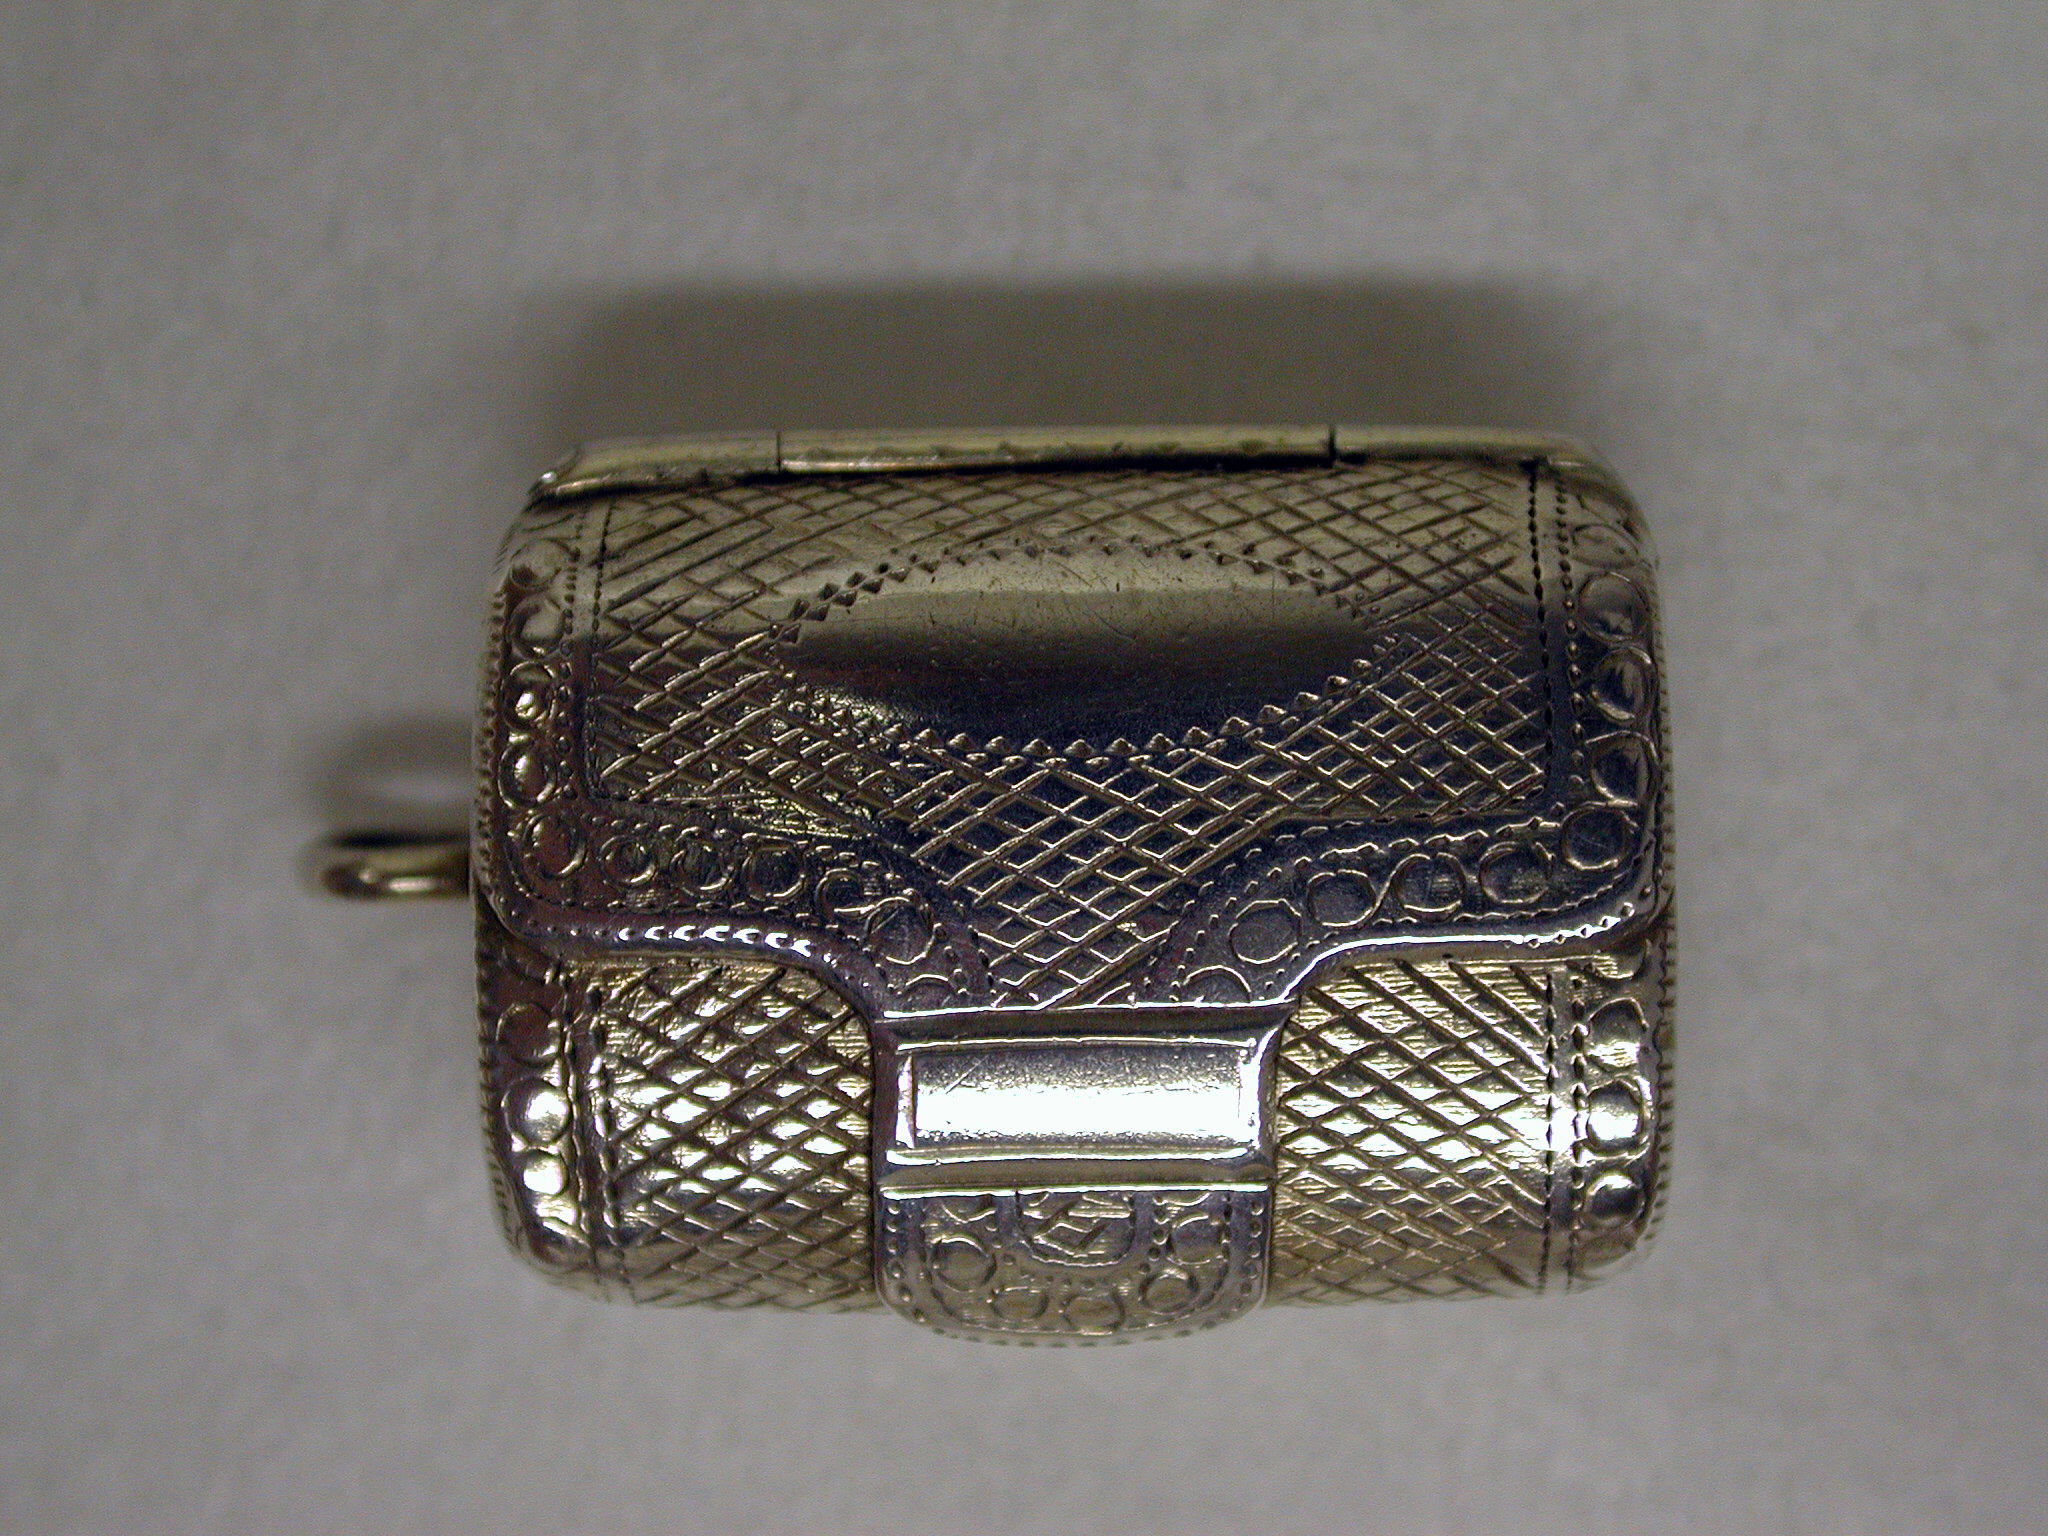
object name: vinaigrette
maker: william lea & co.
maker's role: maker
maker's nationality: british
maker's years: 1811-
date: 1816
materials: silver gilt